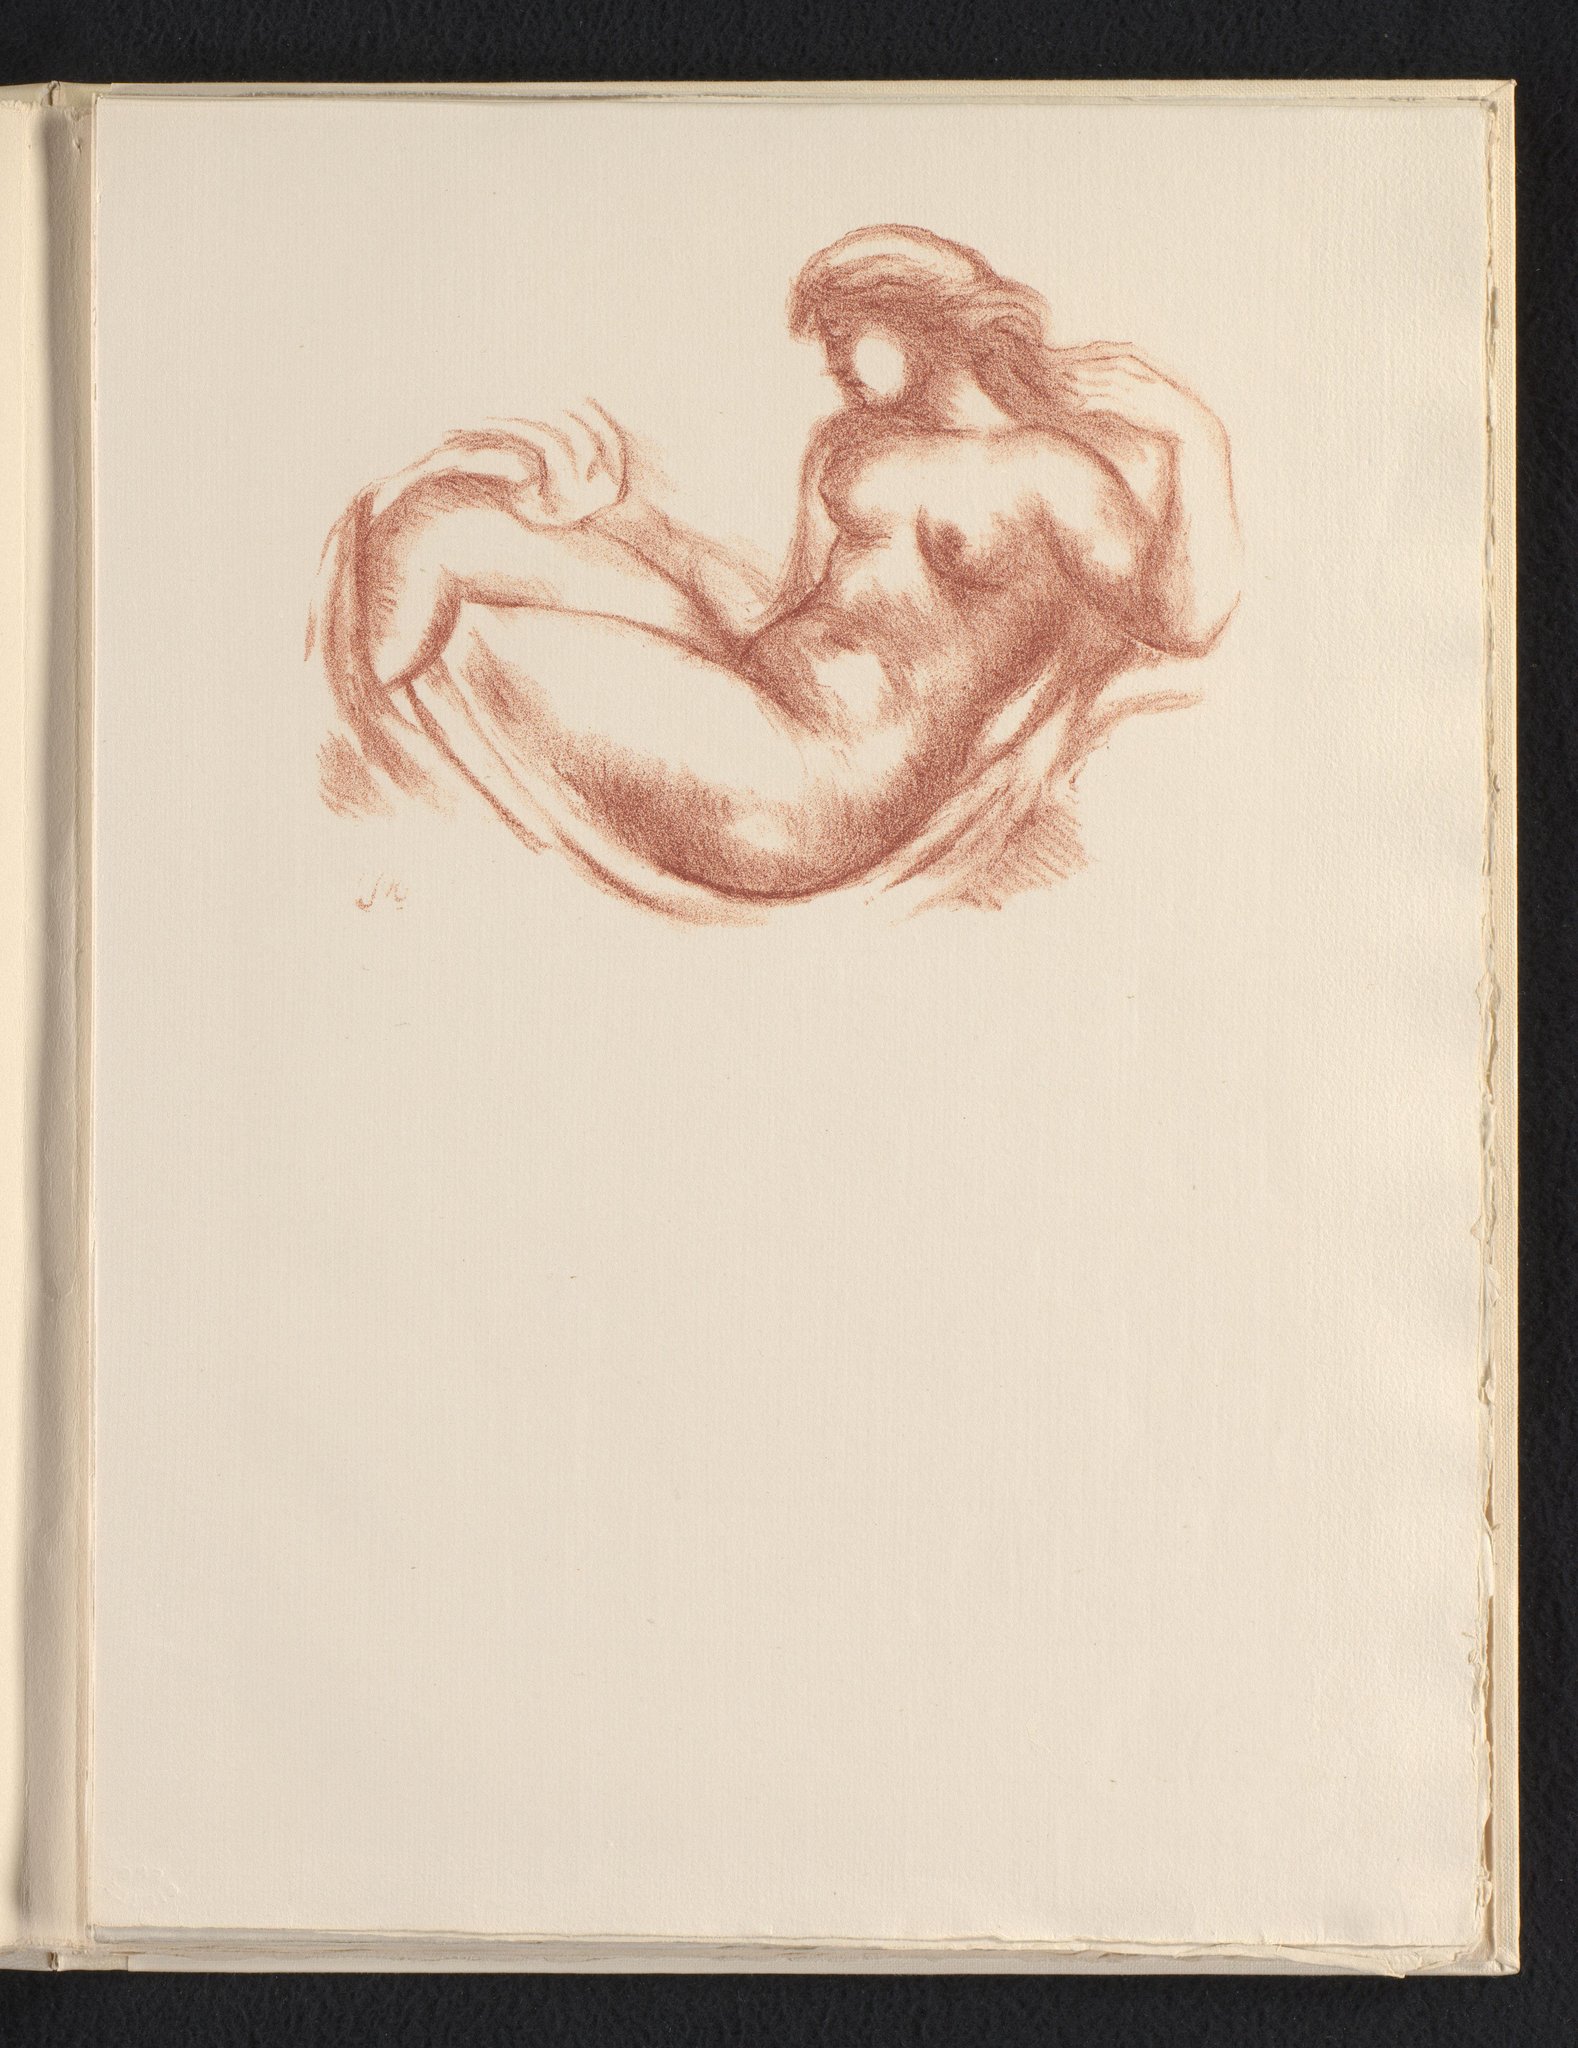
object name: print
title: Achterover leunende naakte vrouw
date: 1948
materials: paper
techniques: lithograph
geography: paris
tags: leaning backward - aa - female human figure, woman (showing herself) undressed, quasi-nude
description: Prent uit: Lucianus van Samosata. Dialogues des Courtisanes. [Vertaald uit het Grieks door] Charles Astruc. Parijs: s.n., 1948, deel van de suite met een extra afdruk van de prenten in sanguine.